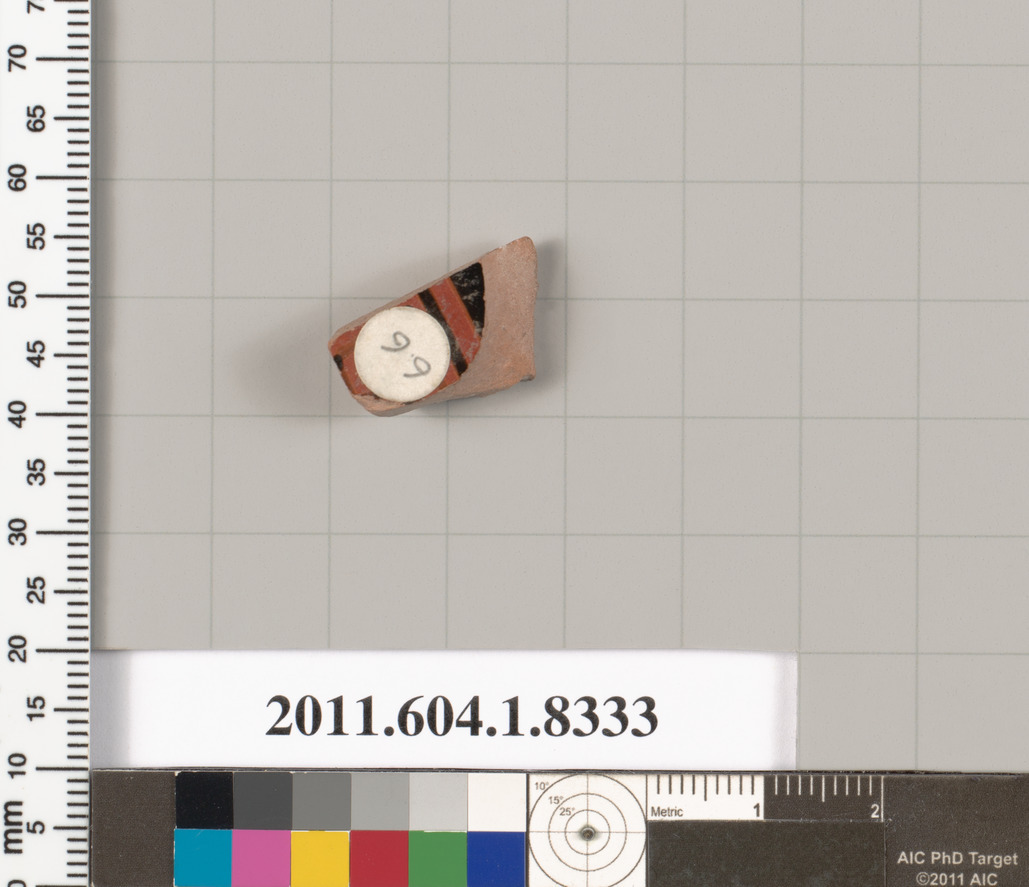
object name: kylix fragment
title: Terracotta fragment of a kylix (drinking cup)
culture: greek, attic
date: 400-376 BCE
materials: terracotta